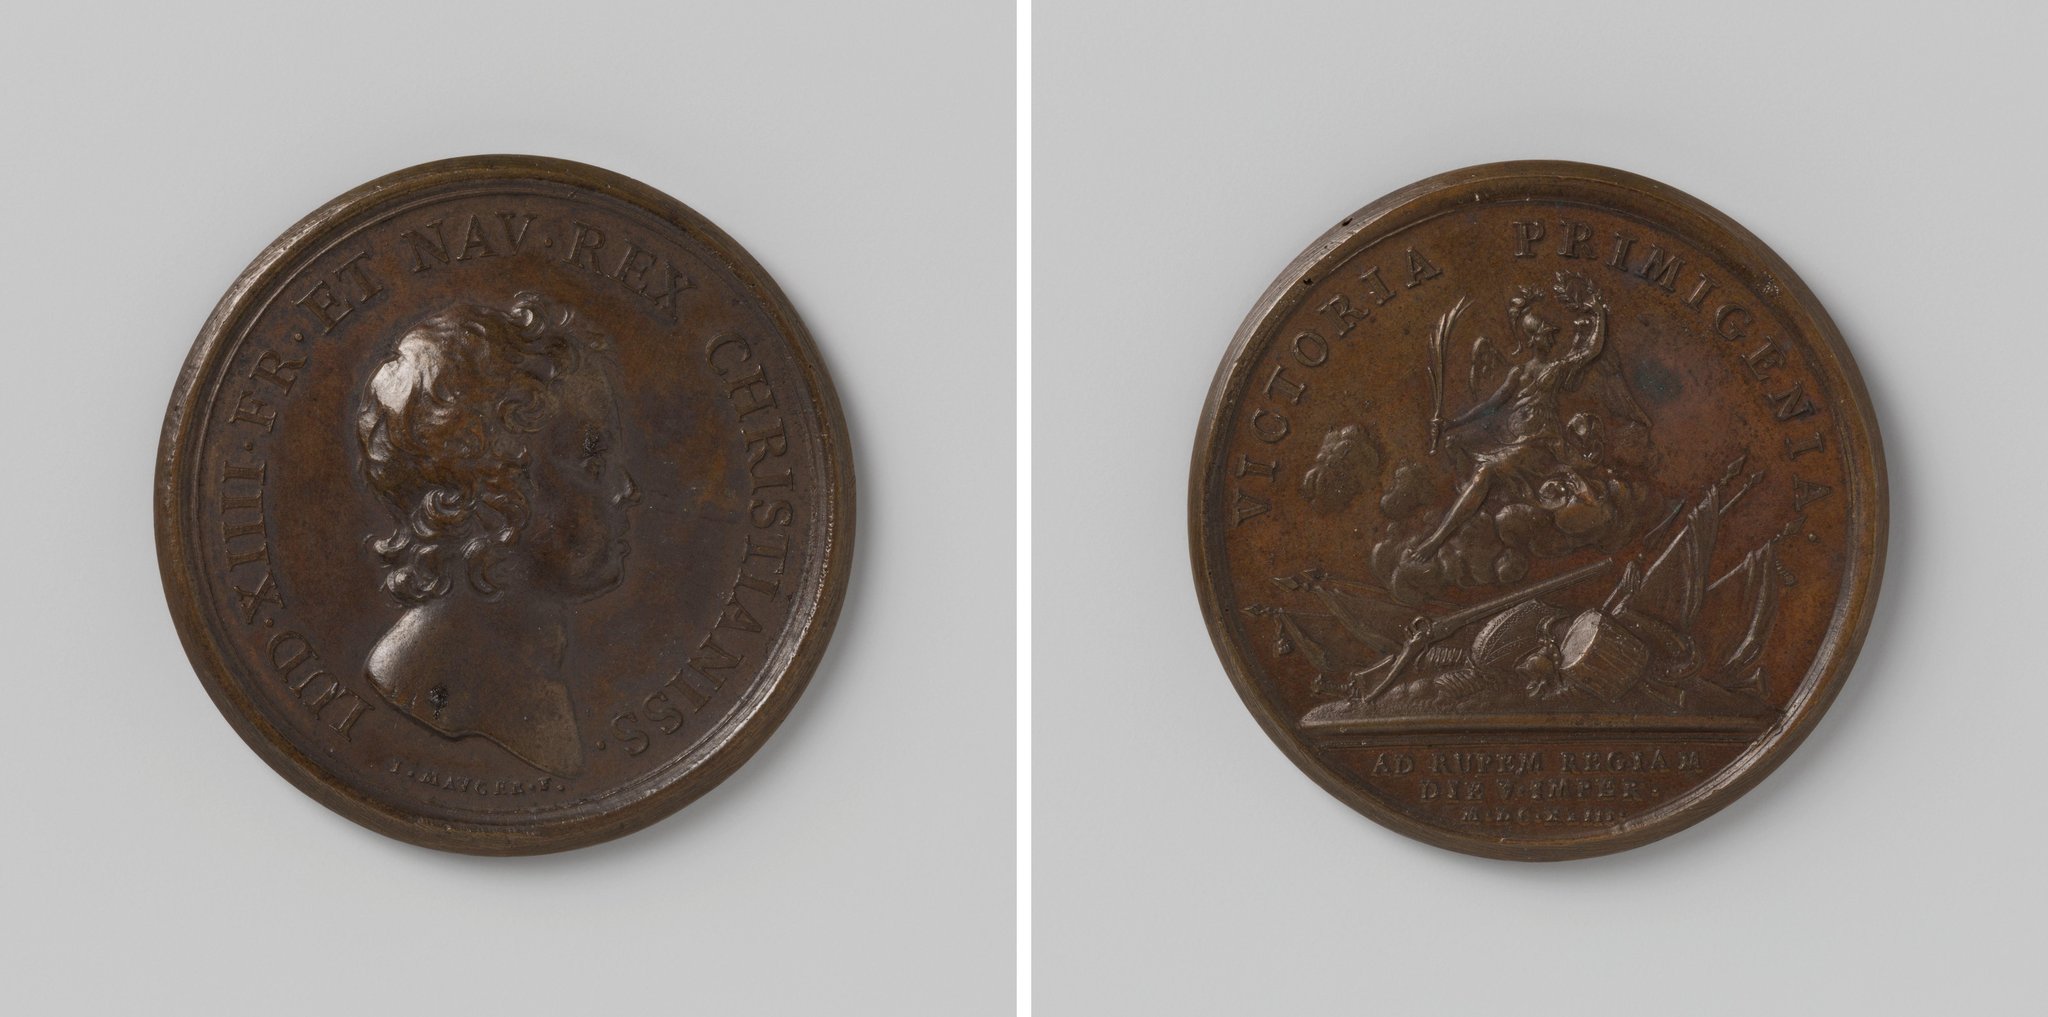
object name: history medal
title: Overwinning op de Spanjaarden bij Rocroi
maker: jean mauger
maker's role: medailleur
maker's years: 1648-1722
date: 1699-1703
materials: bronze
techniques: striking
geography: paris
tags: lodewijk xiv (koning van frankrijk), france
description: Bronzen penning. Voorzijde: borststuk jongen (Lodewijk XIV) binnen omschrift. Keerzijde: Overwinning met zegepalm en lauwerkrans gezeten op wolk boven trophee, opgebouwd uit krijgstuig en vaandels binnen omschrift; afsnede: opschrift